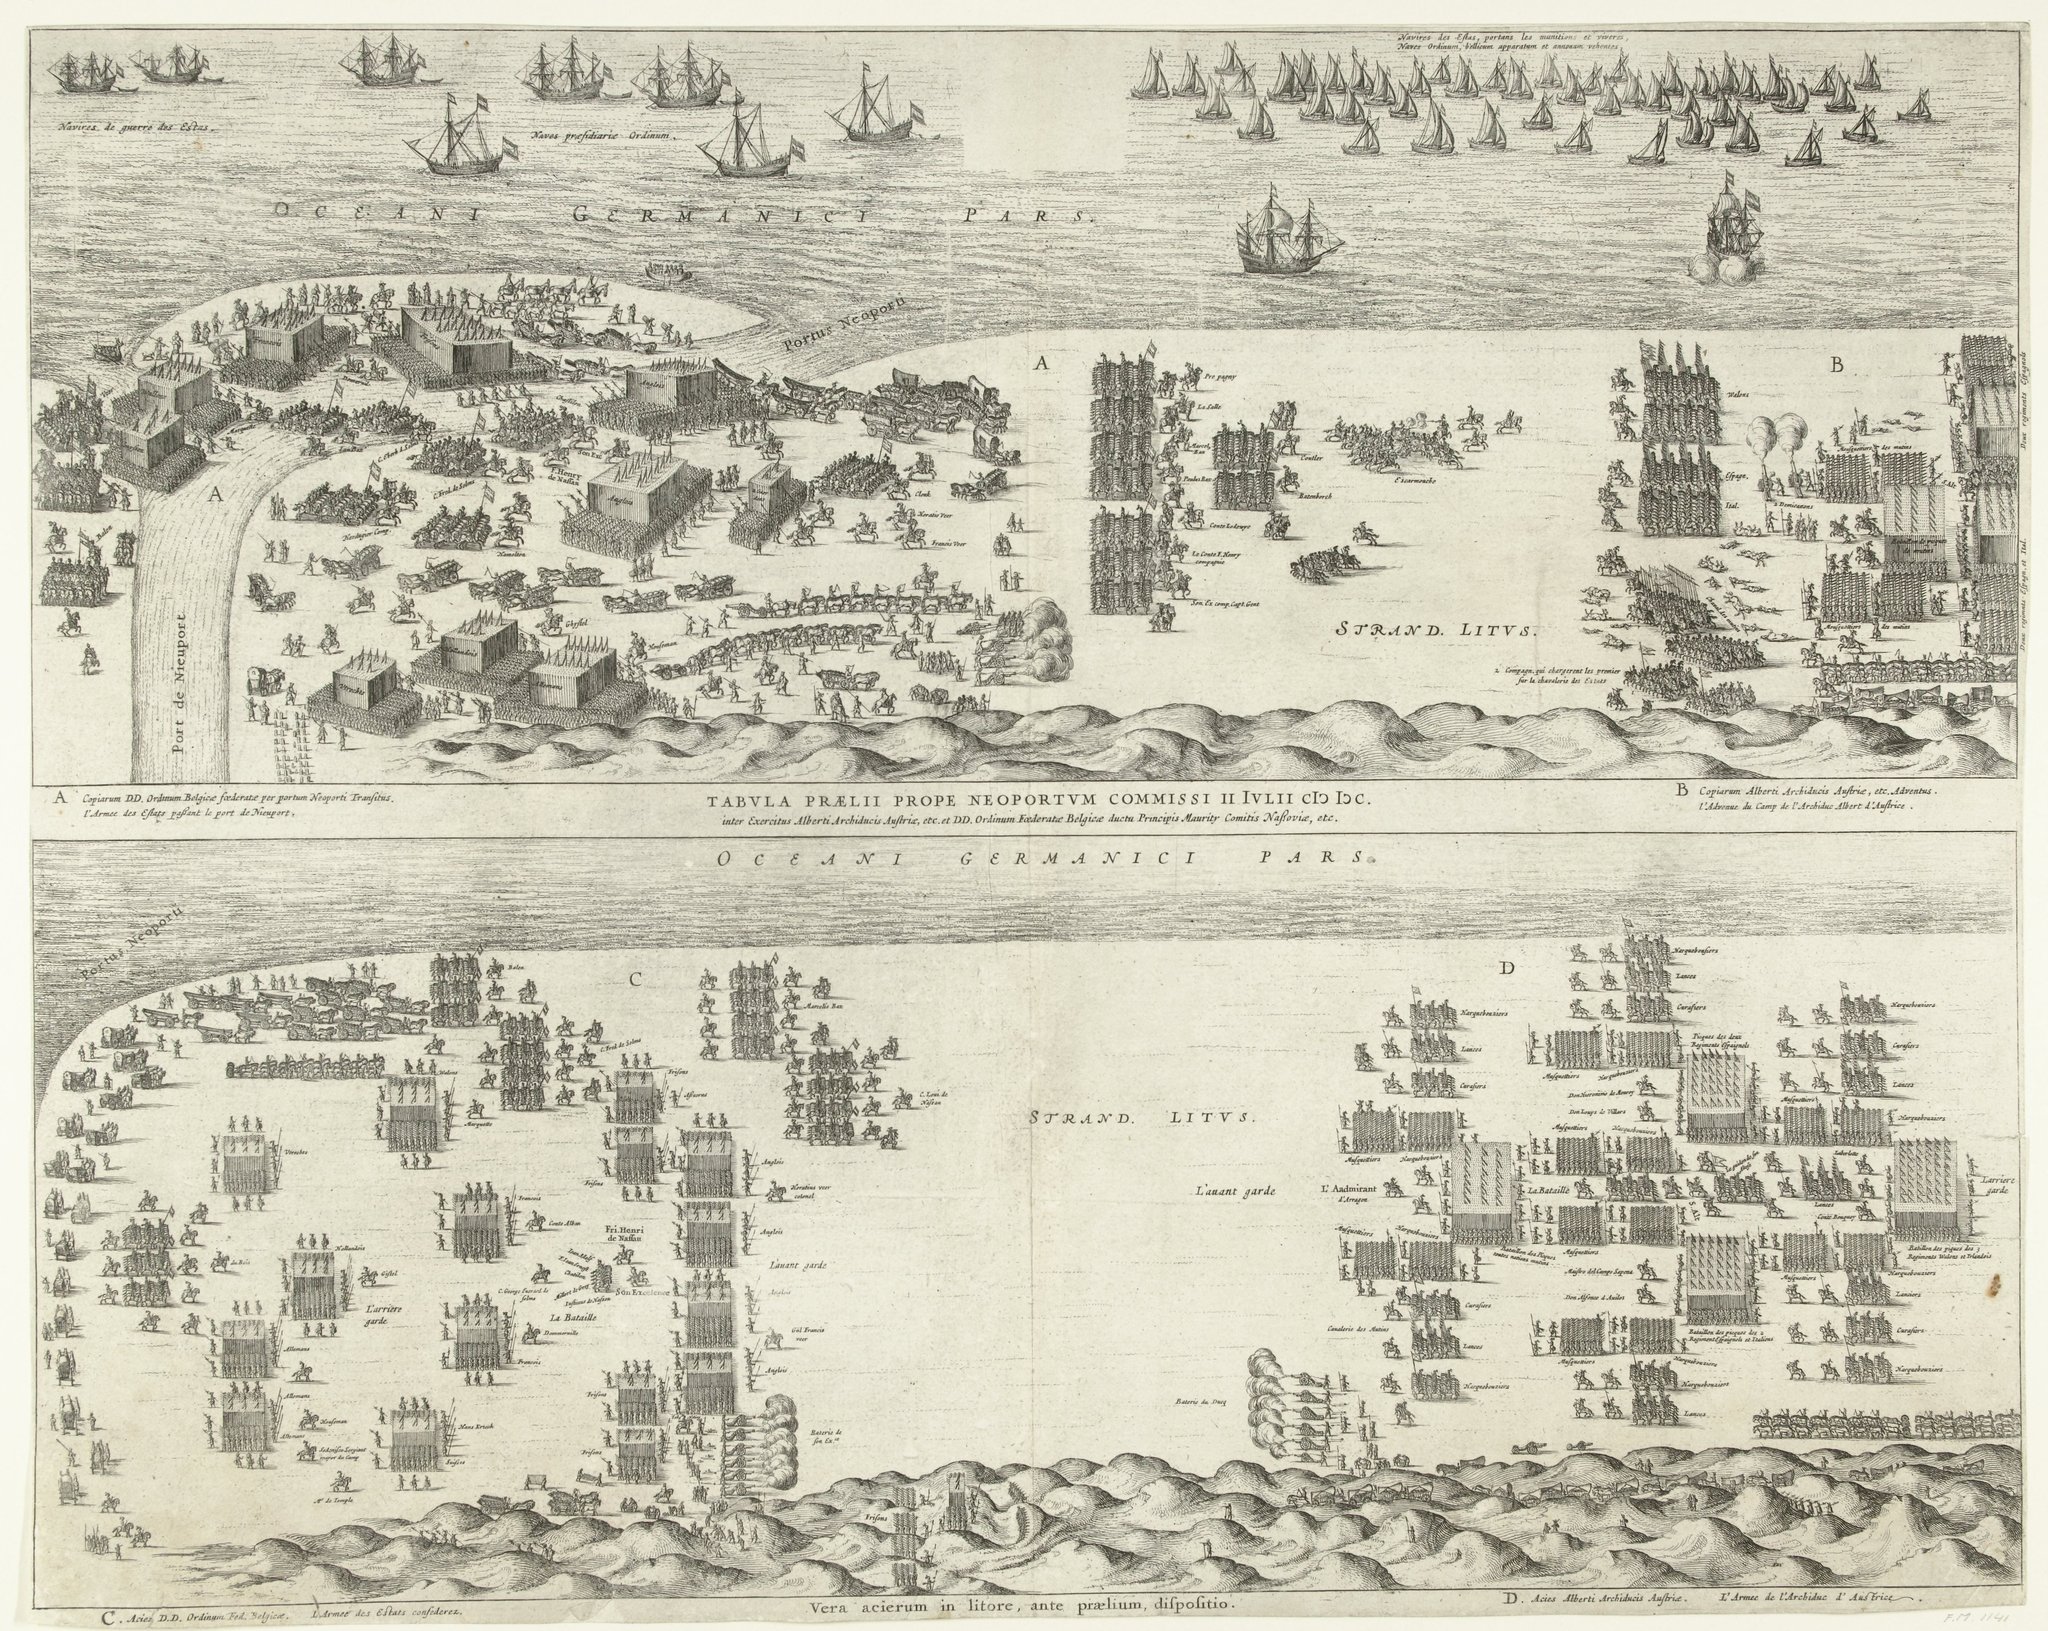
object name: history print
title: Twee voorstellingen; boven: het Staatse leger steekt de haven bij Nieuwpoort over en de Staatse en Spaanse legers tegenover elkaar op het strand bij Nieuwpoort; onder: de slagordes en eerste schermutselingen tussen Staatse en Spaanse soldaten op het strand bij Nieuwpoort, 1600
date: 1647-1649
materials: paper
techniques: etching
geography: northern netherlands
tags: maurice (prince of orange), brussels, albrecht aartshertog van oostenrijk, troop movements, transportation, battle (+ land forces), battle of nieuwpoort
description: Illustratie afkomstig uit: Novum ac magnum theatrum urbium Belgicae liberae ac foederatae, Joan Blaeu, Amsterdam 1649, 2 delen.